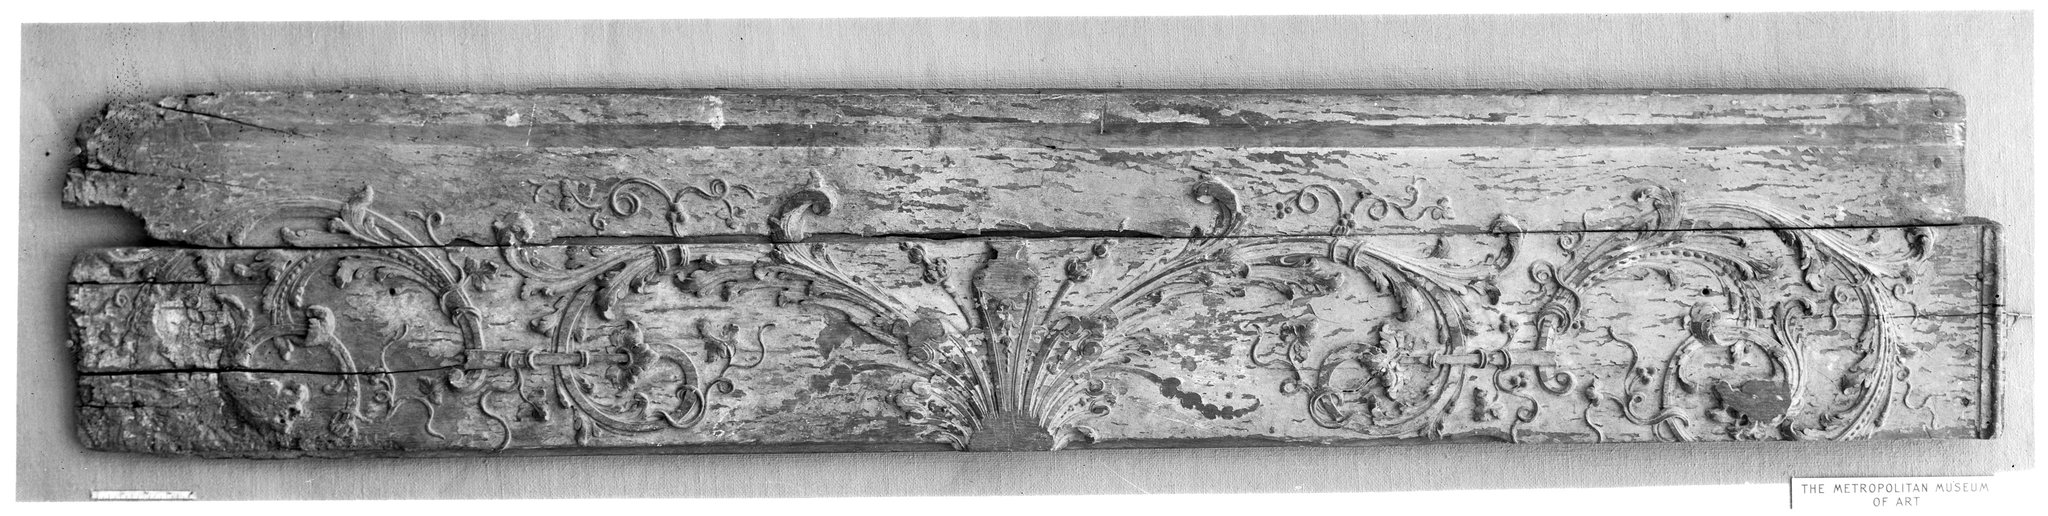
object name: panel fragment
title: Panel fragment (dessus d'alcove)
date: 1701-1725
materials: wood